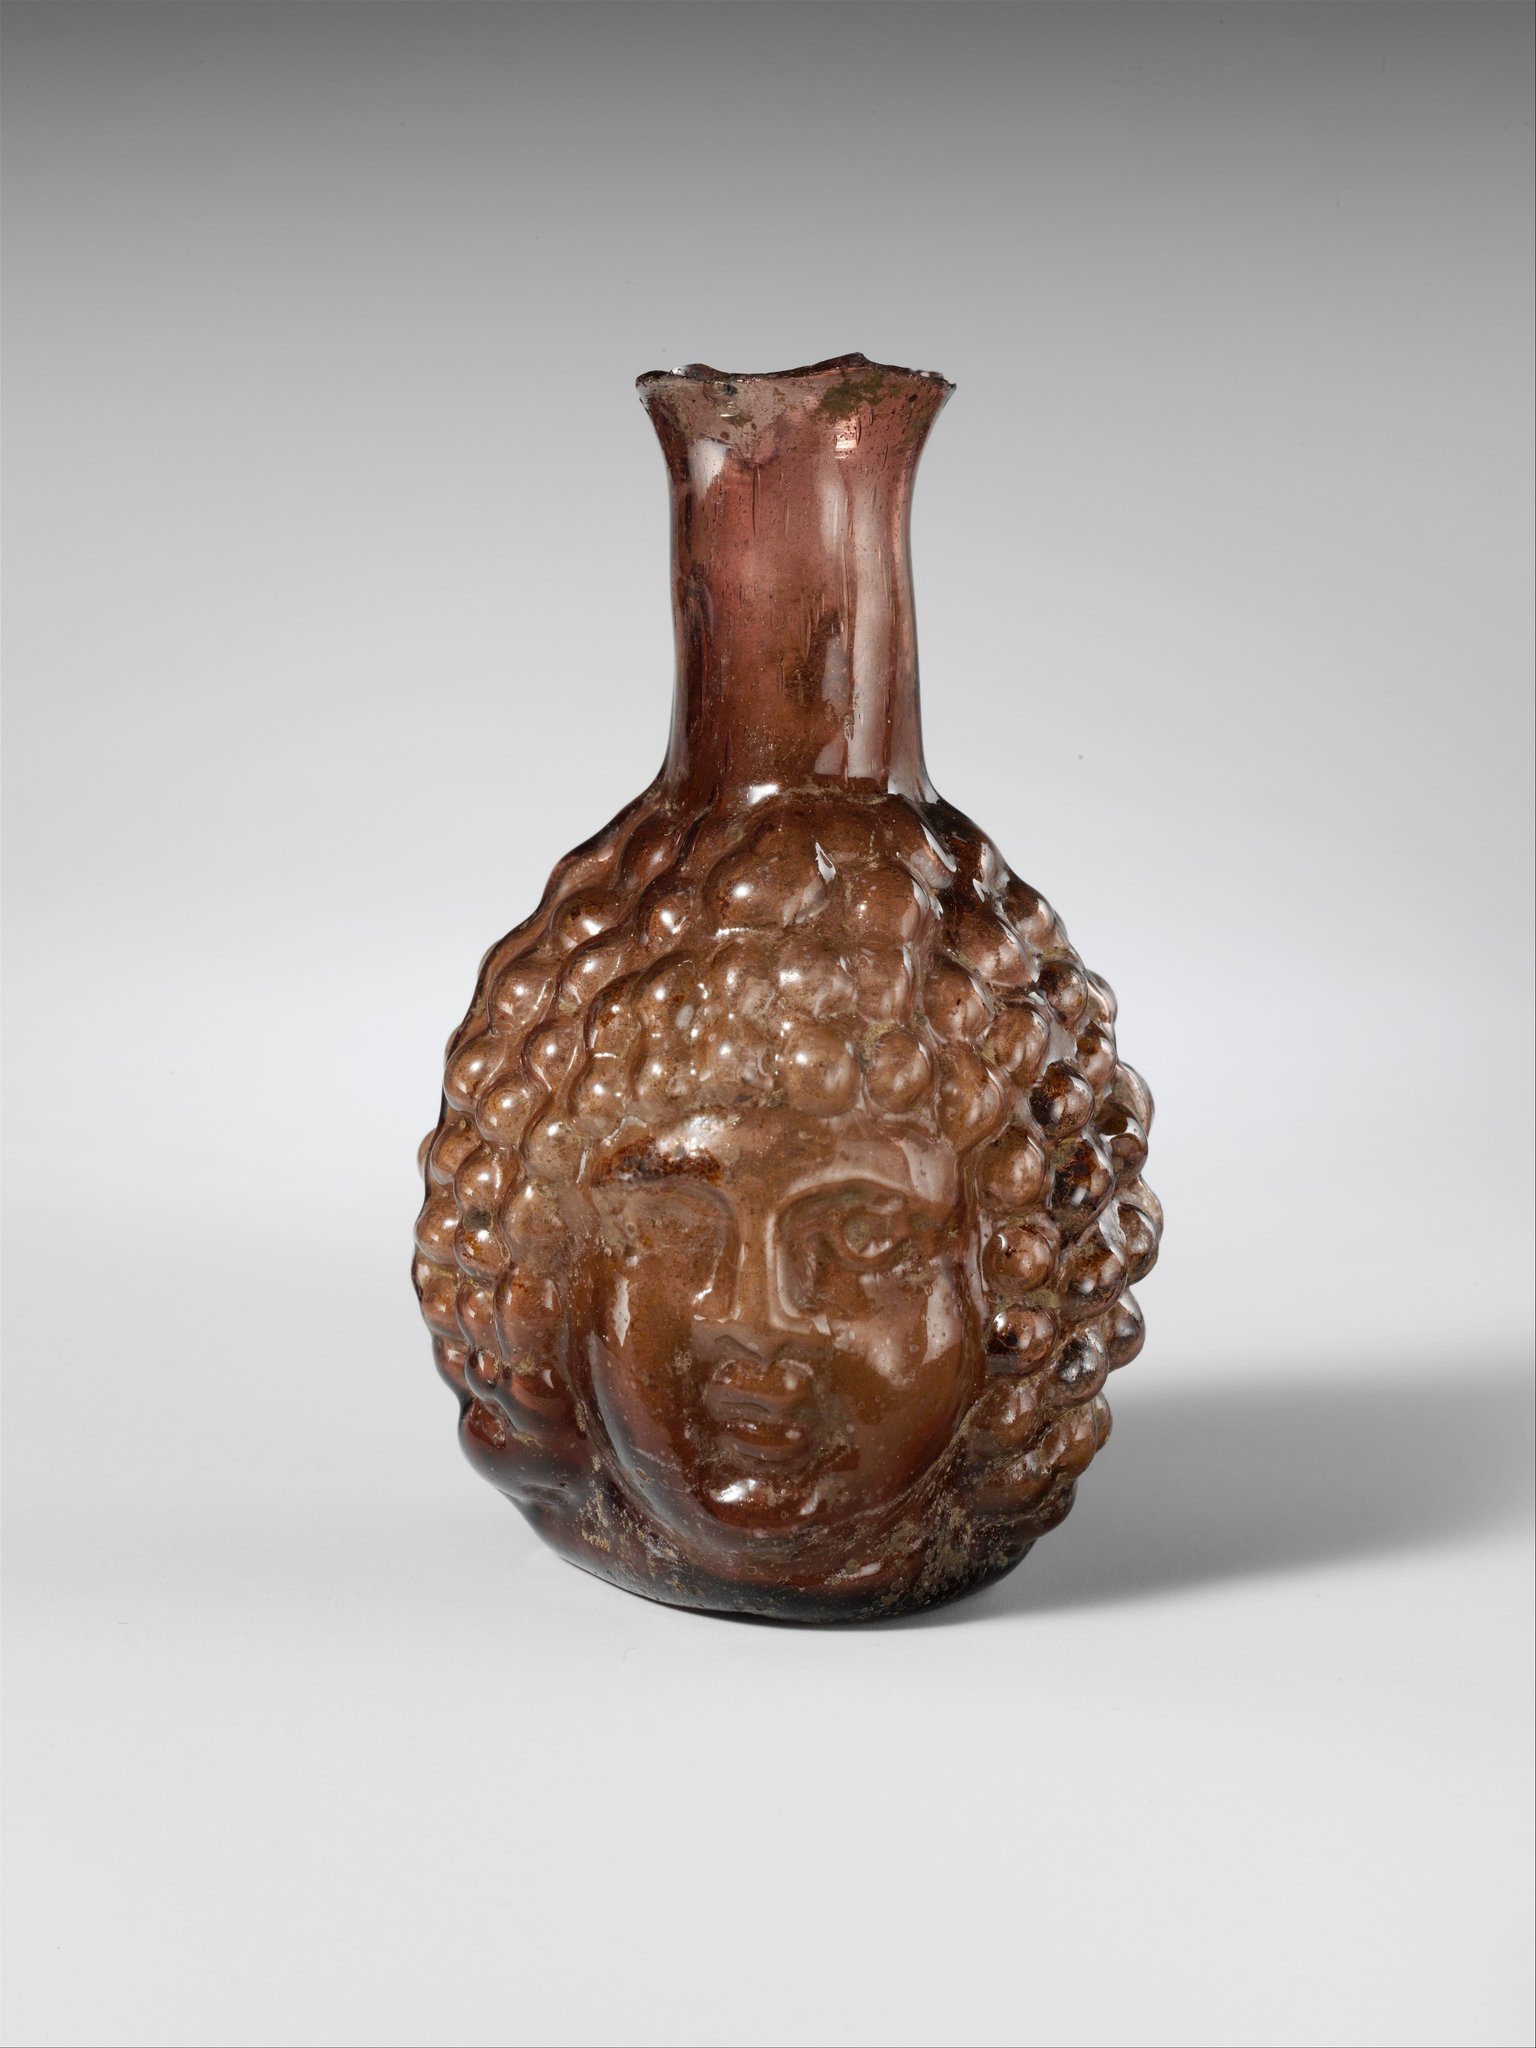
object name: flask, double head shaped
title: Glass double head-shaped flask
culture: roman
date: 201-233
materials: glass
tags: heads